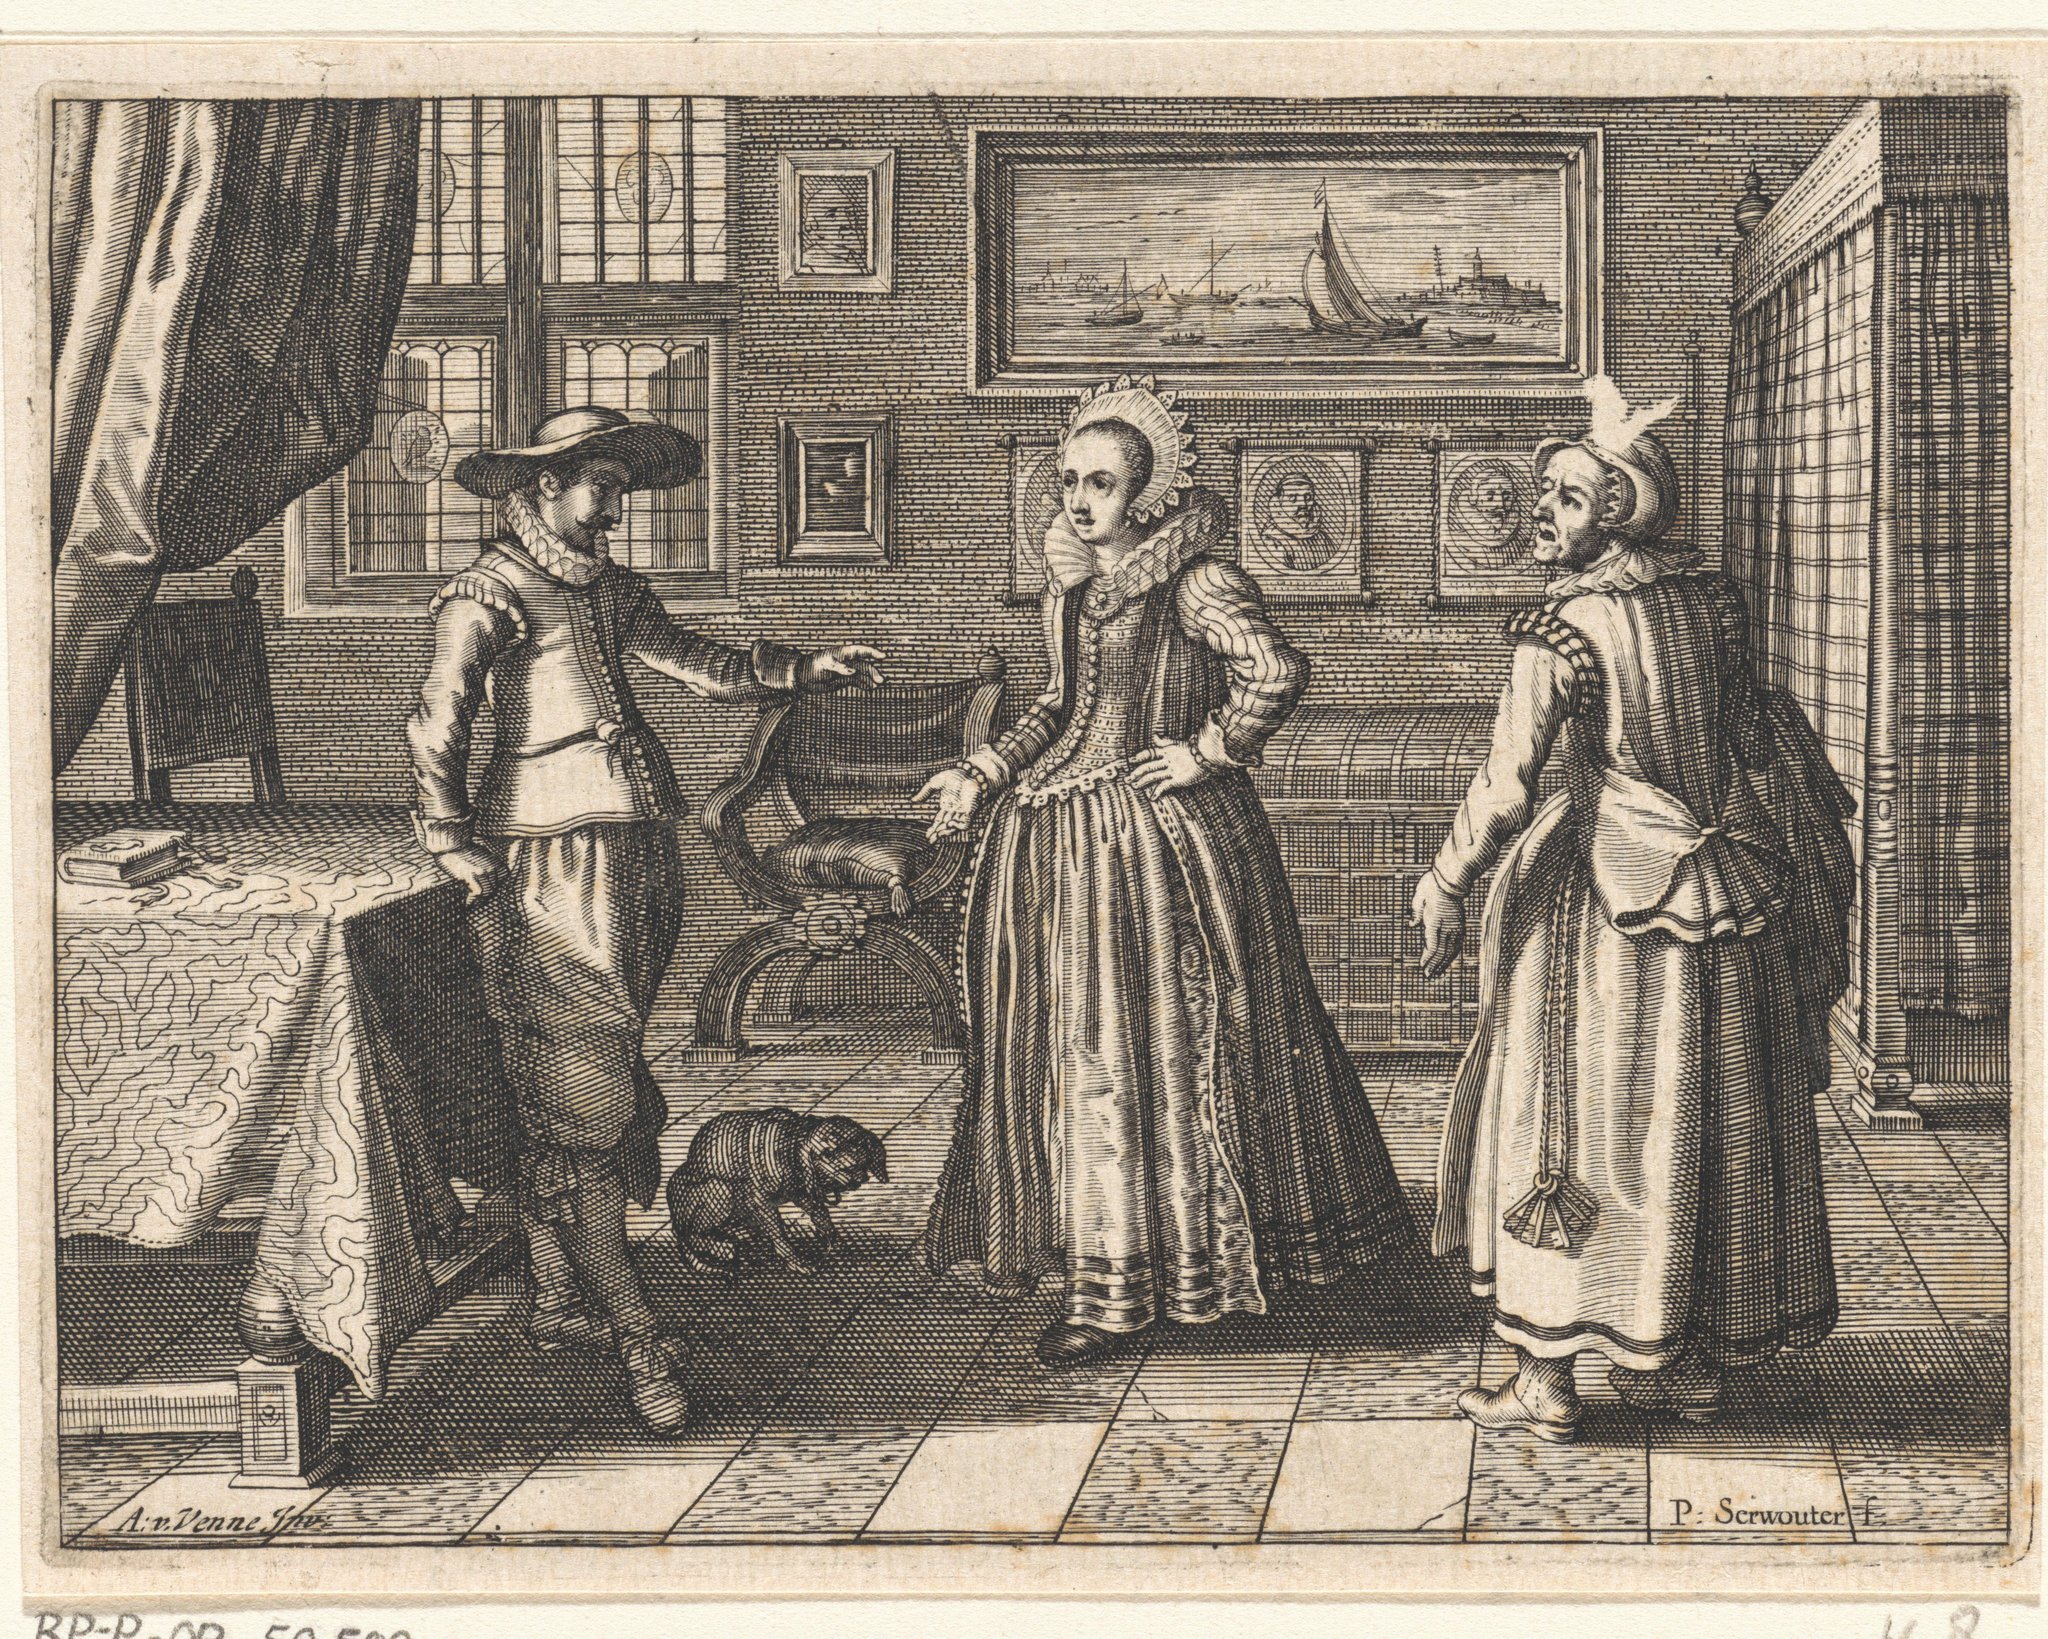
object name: print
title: Paar en bediende in een interieur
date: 1625-1633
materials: paper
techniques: engraving, letterpress printing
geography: amsterdam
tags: bed with tester, picture, painting, quarrel, argument, living-room, parlour, sitting-room, dog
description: Een man en vrouw staan te praten in een rijk interieur met verschillende schilderijen aan de muur. Een ineengedoken hondje zit aan hun voeten. Een oude vrouw richt zich samen met de jongere tot de man.